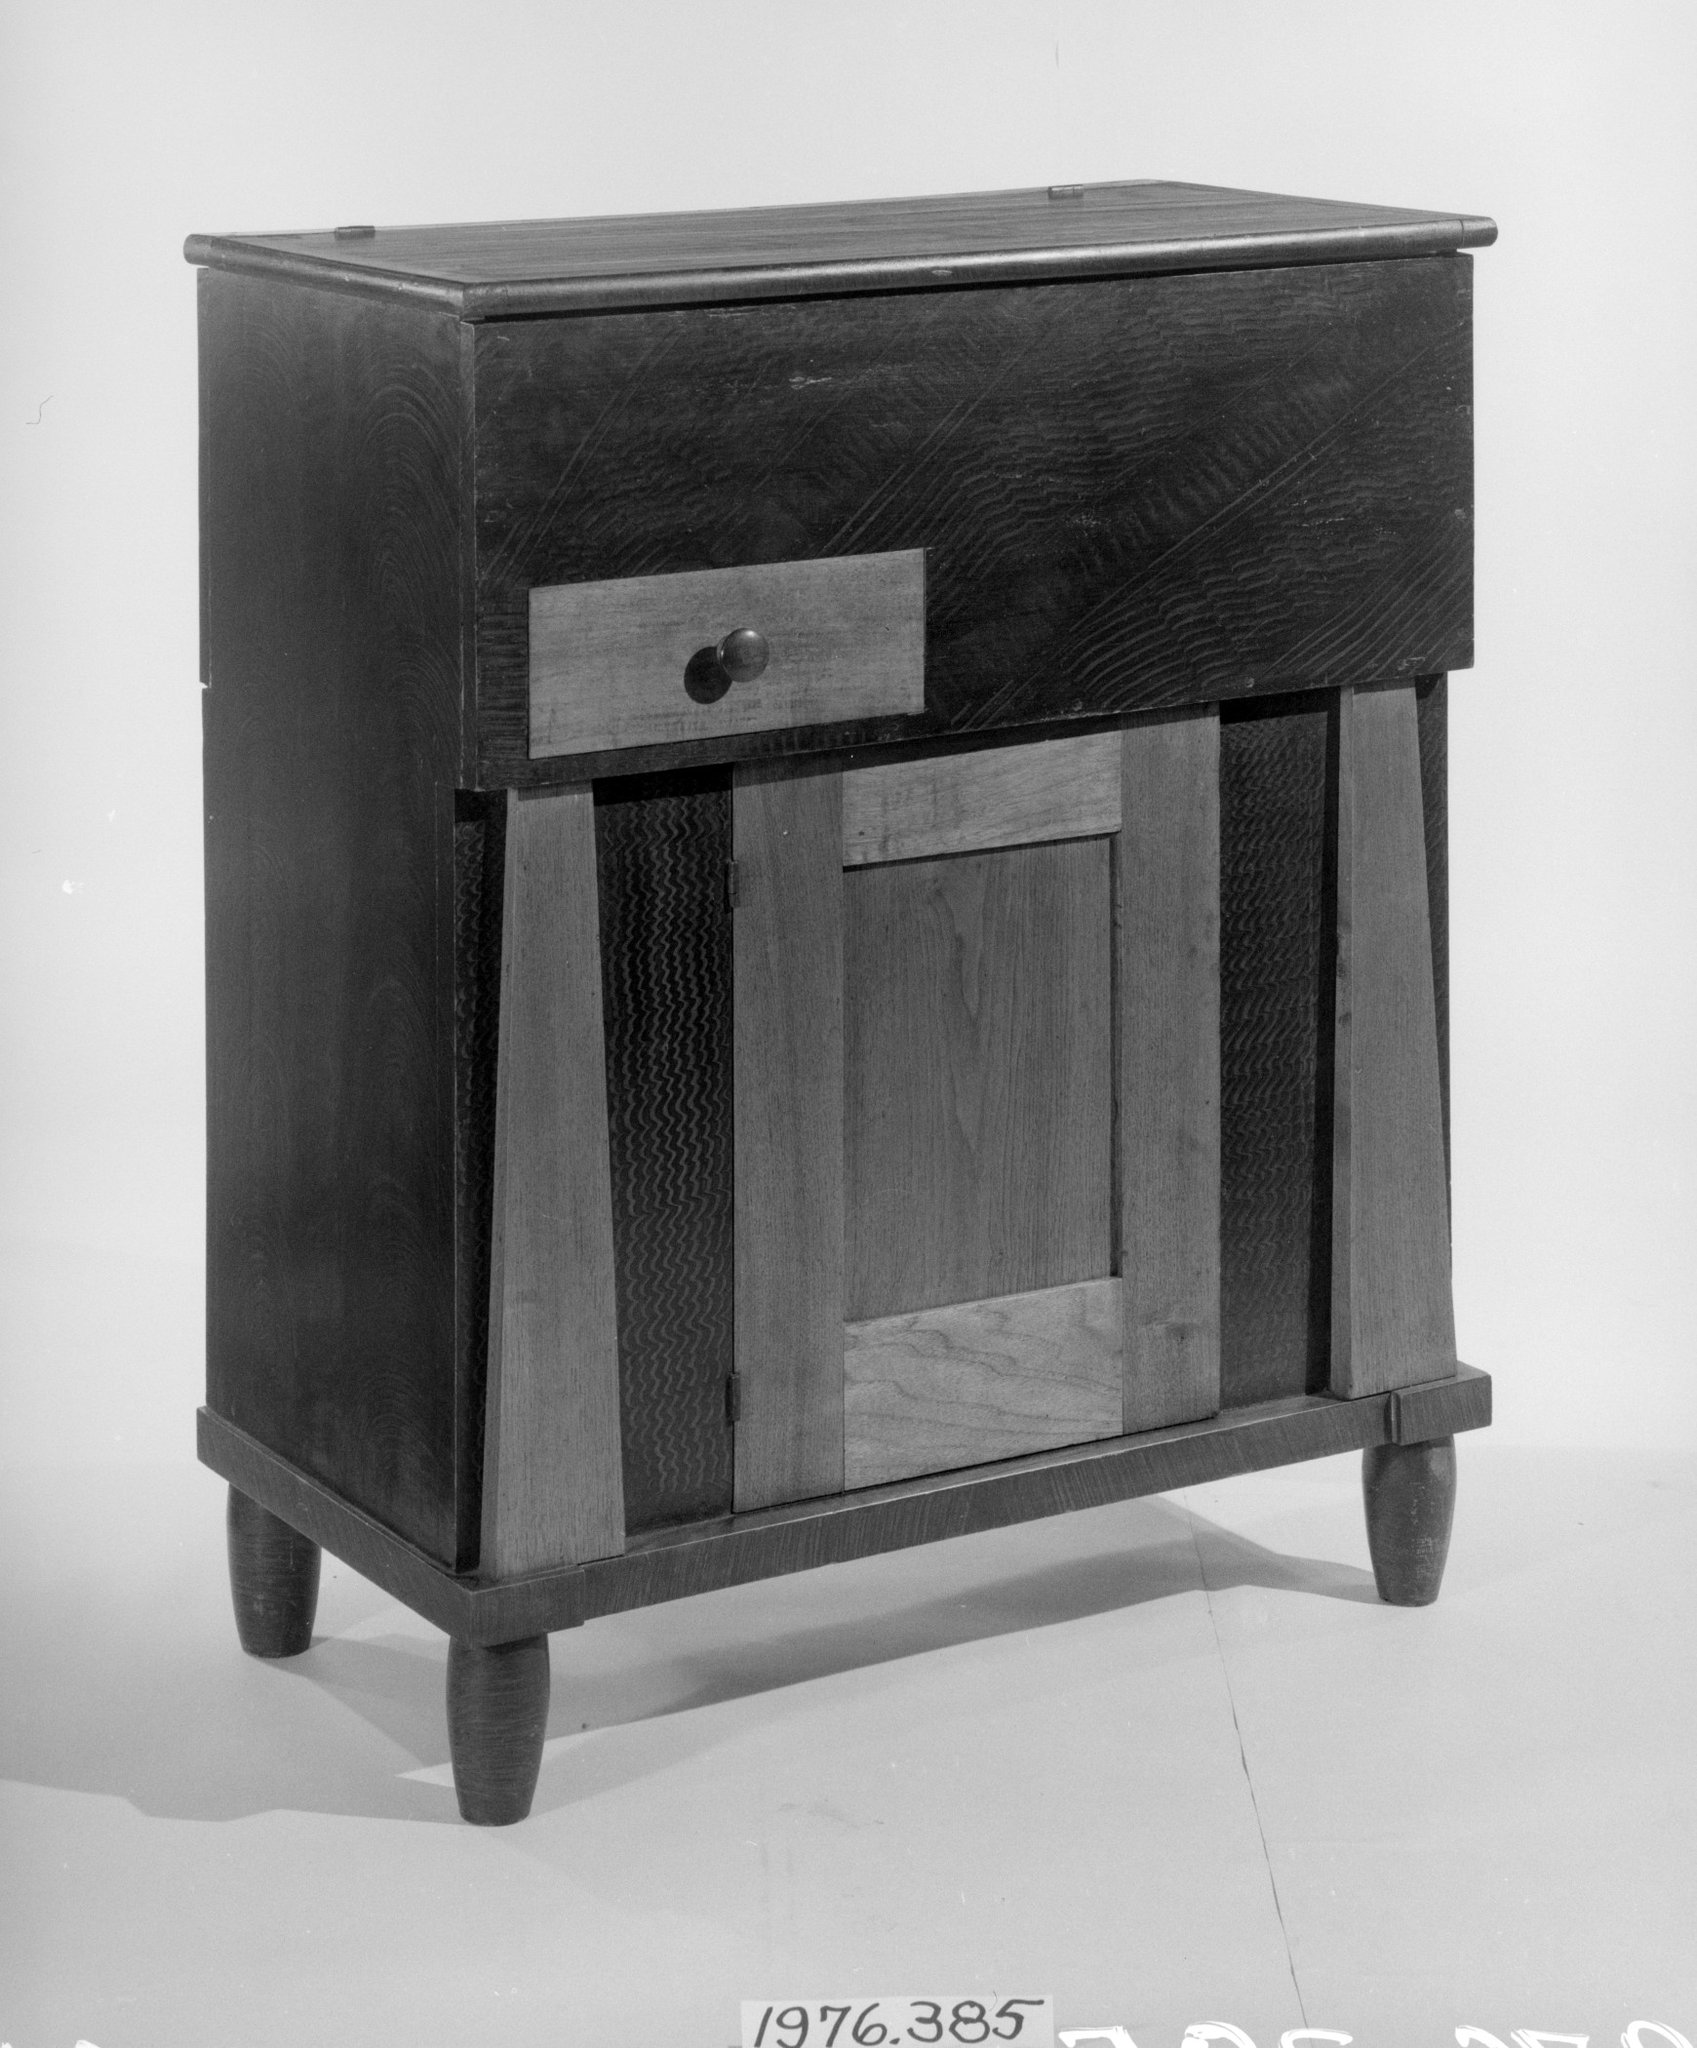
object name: commode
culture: american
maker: stephen a. fish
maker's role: maker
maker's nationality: american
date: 1856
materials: wood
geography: united states